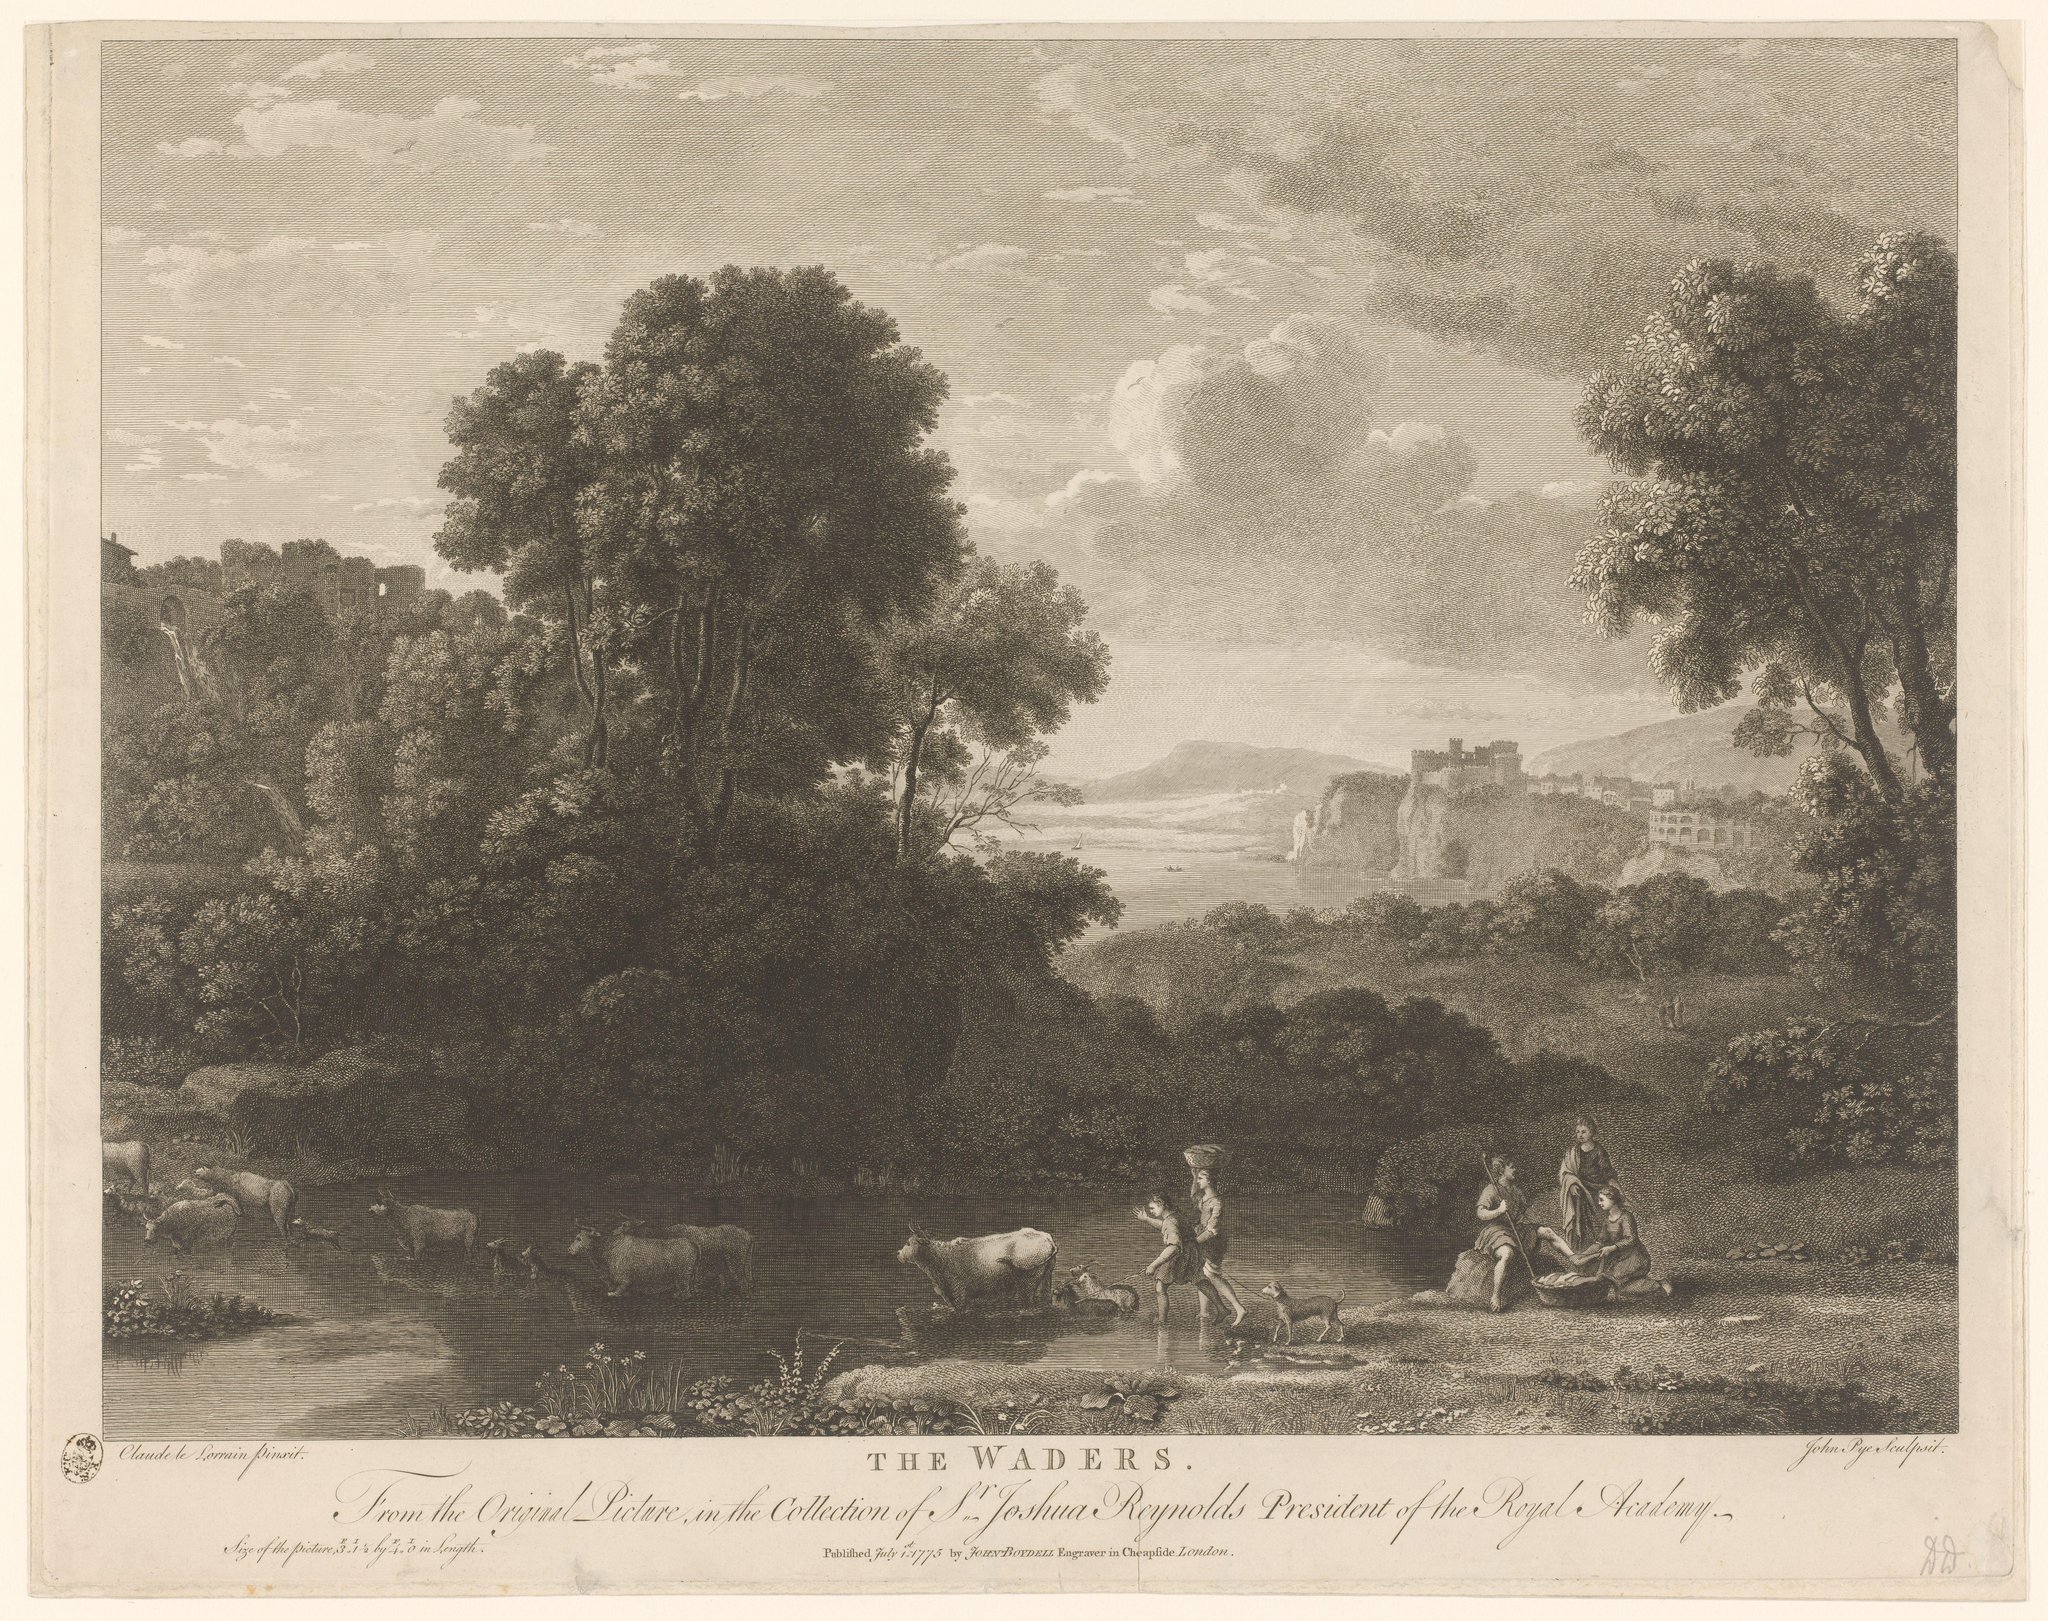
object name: print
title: The Waders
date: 1707-1775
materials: paper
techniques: engraving, etching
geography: london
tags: river - hh - ideal landscapes, herding, herdsman, herdswoman, shepherd, shepherdess, cowherd, etc., cattle driving, cattle driver, landscape with tower or castle - ii - ideal landscapes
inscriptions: collector's mark: Lugt 2228, collector's mark: Lugt 1647, collector's mark: Lugt 1618